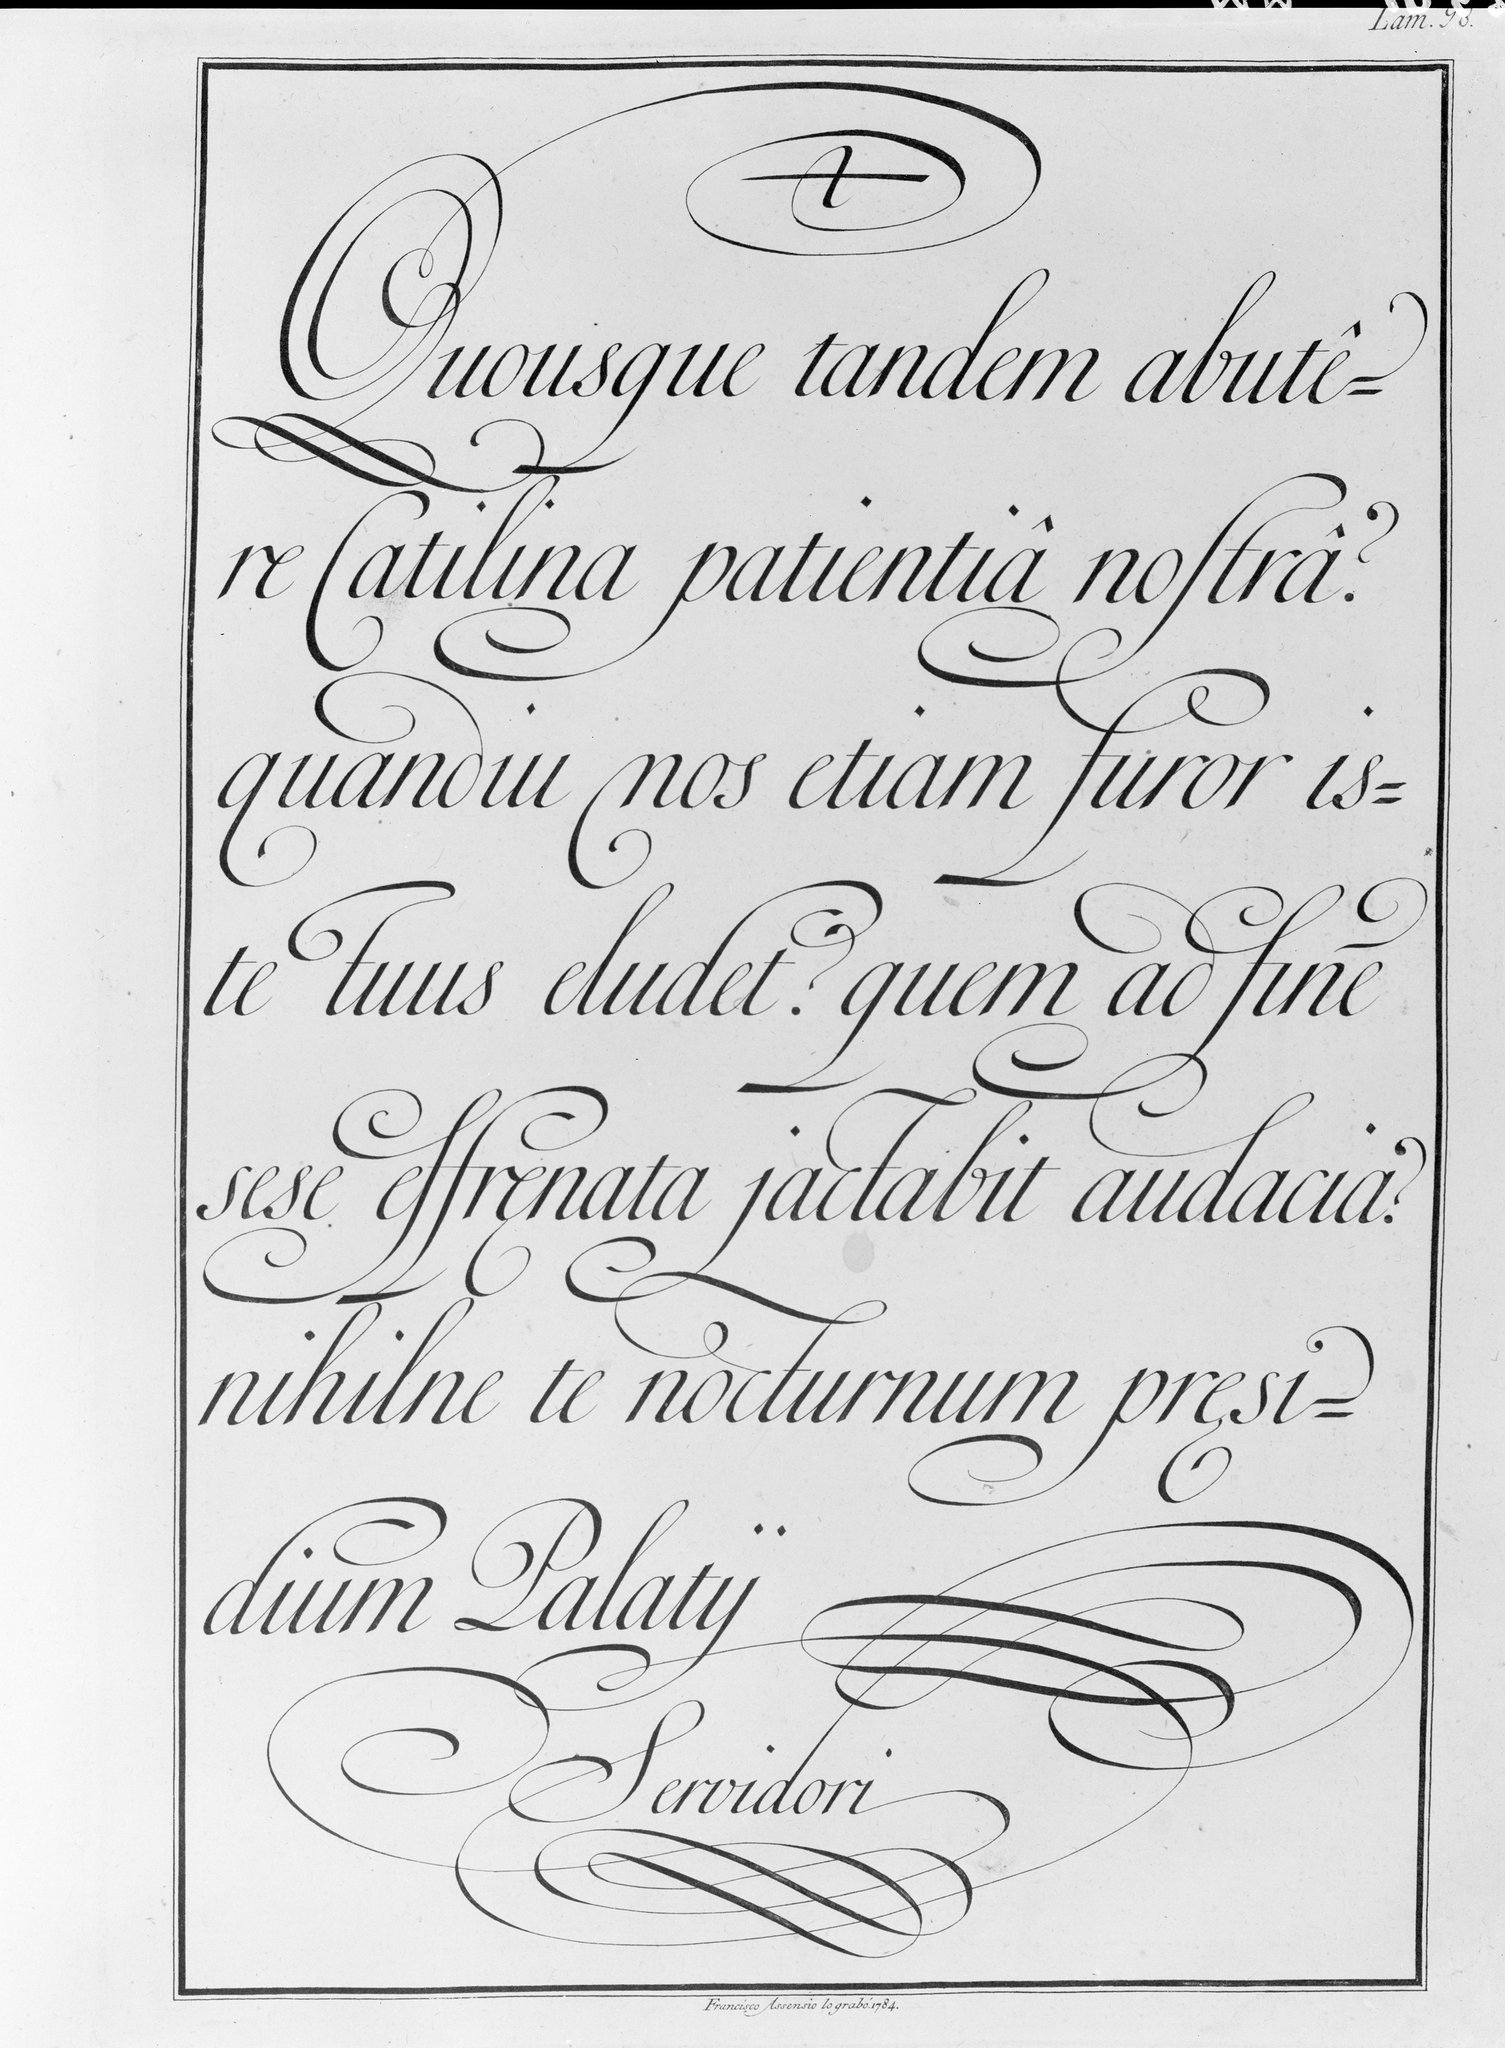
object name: book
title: Laminas de las Reflexiones...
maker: don domingo maria de servidori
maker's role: author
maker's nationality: spanish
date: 1789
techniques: engraving